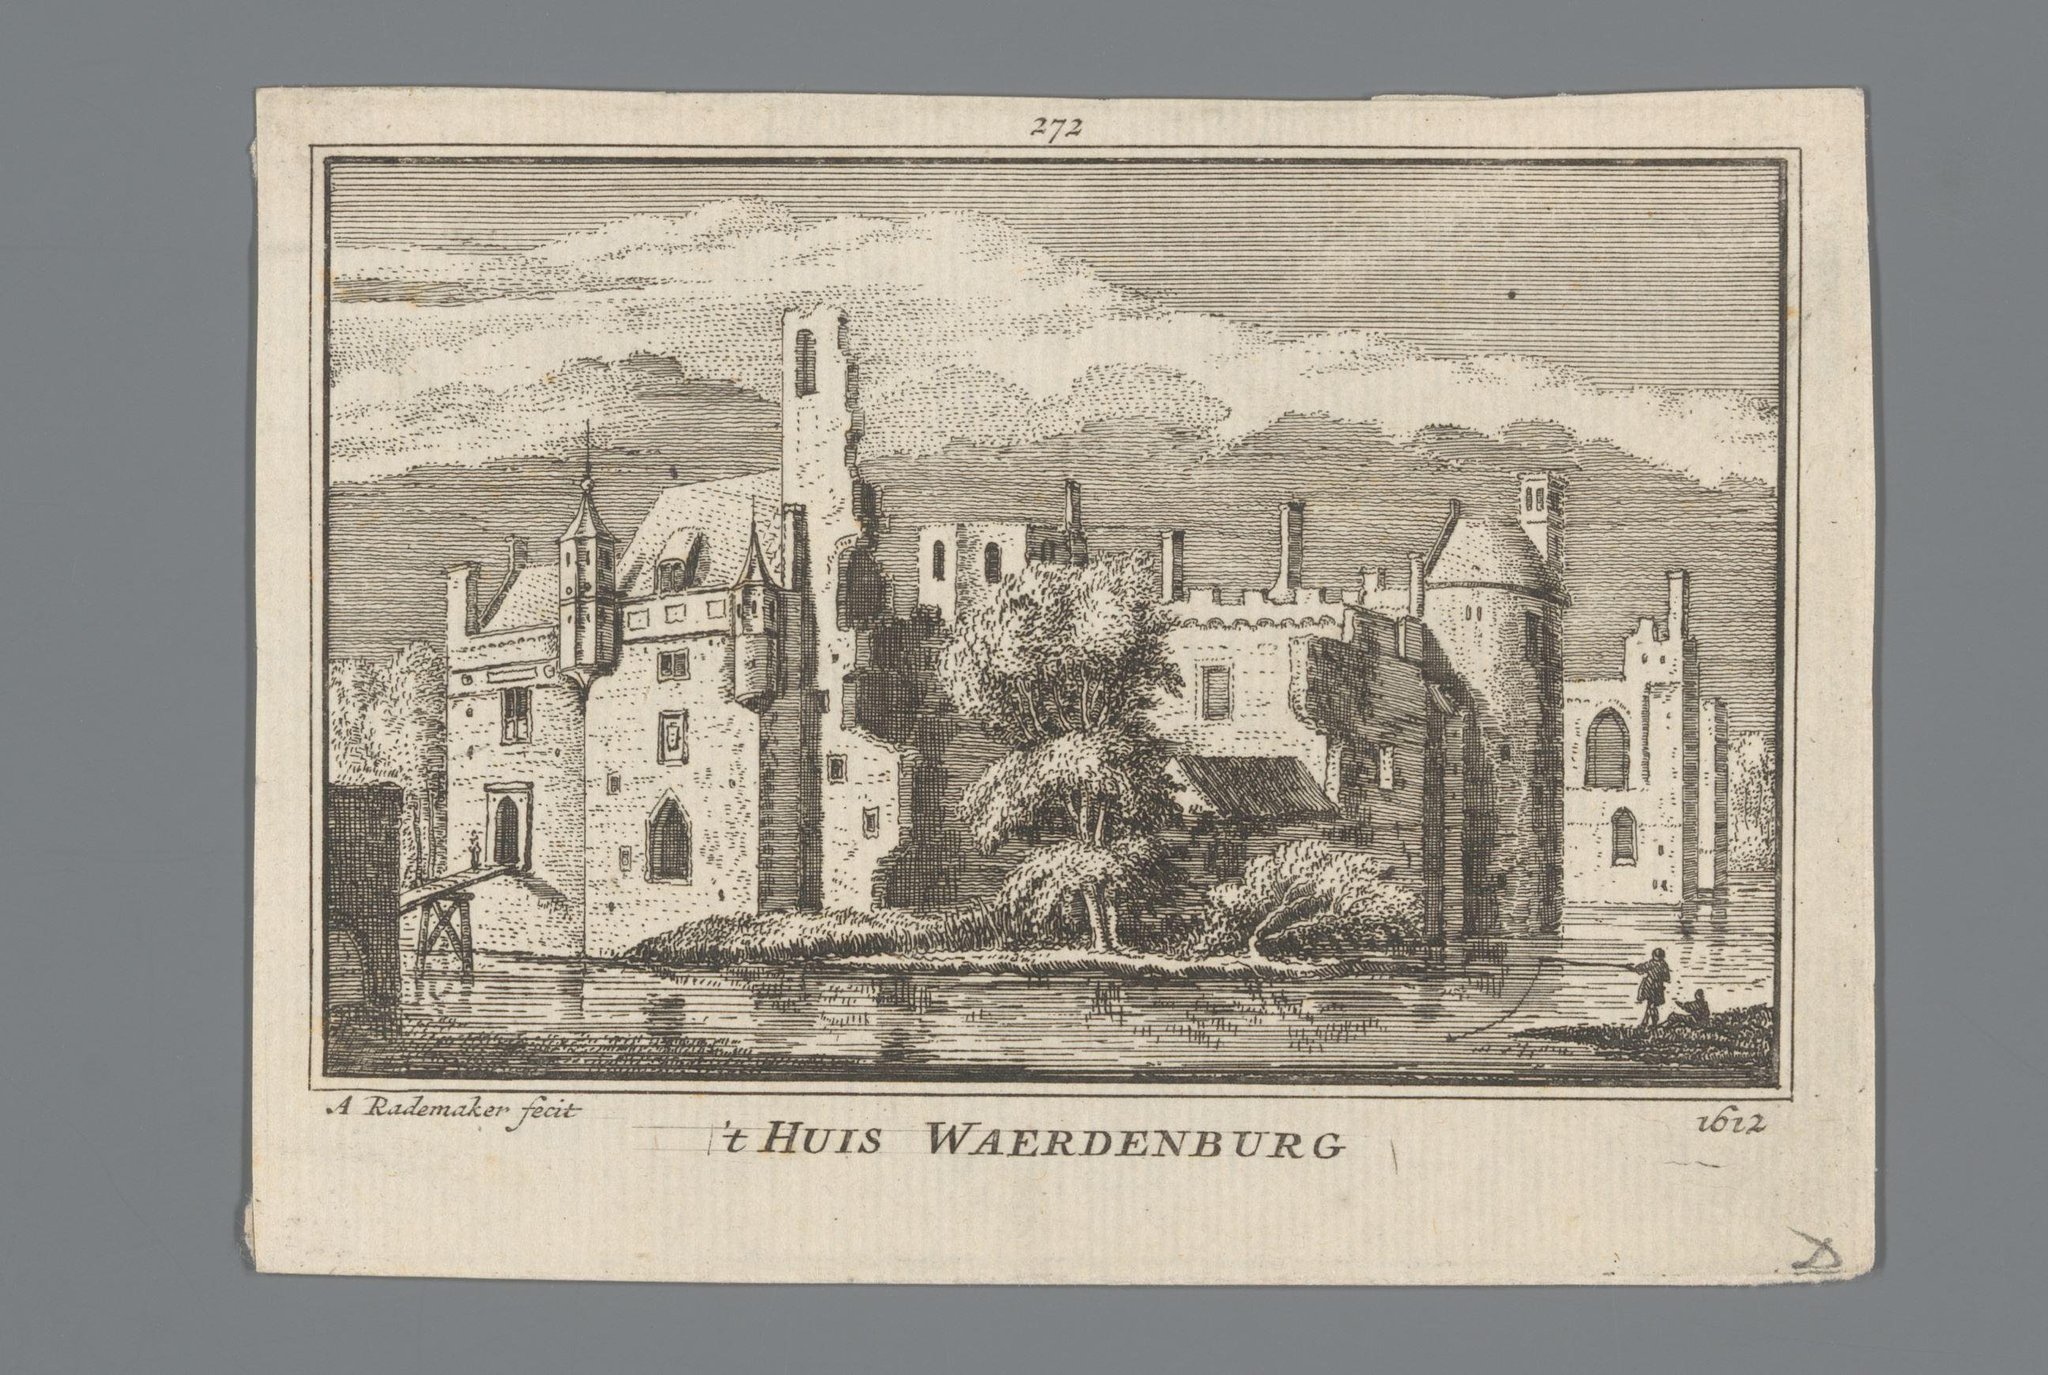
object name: print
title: Gezicht op de ruïne van Kasteel Waardenburg, 1612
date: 1725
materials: paper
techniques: etching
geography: amsterdam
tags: landscape with ruins, ruin of a dwelling, house, castle, etc.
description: Prent voor het eerst gebruikt in: Rademaker, Abraham. Kabinet van Nederlandsche outheden en gezichten: vervat in 300 konstplaaten (…). 2 dln. Amsterdam: Willem Barents, 1725, ill. 272. Daarna is de prent in verschillende heruitgaven verschenen, uitgegeven in 1727-1733, 1770-1771 en 1792-1803.